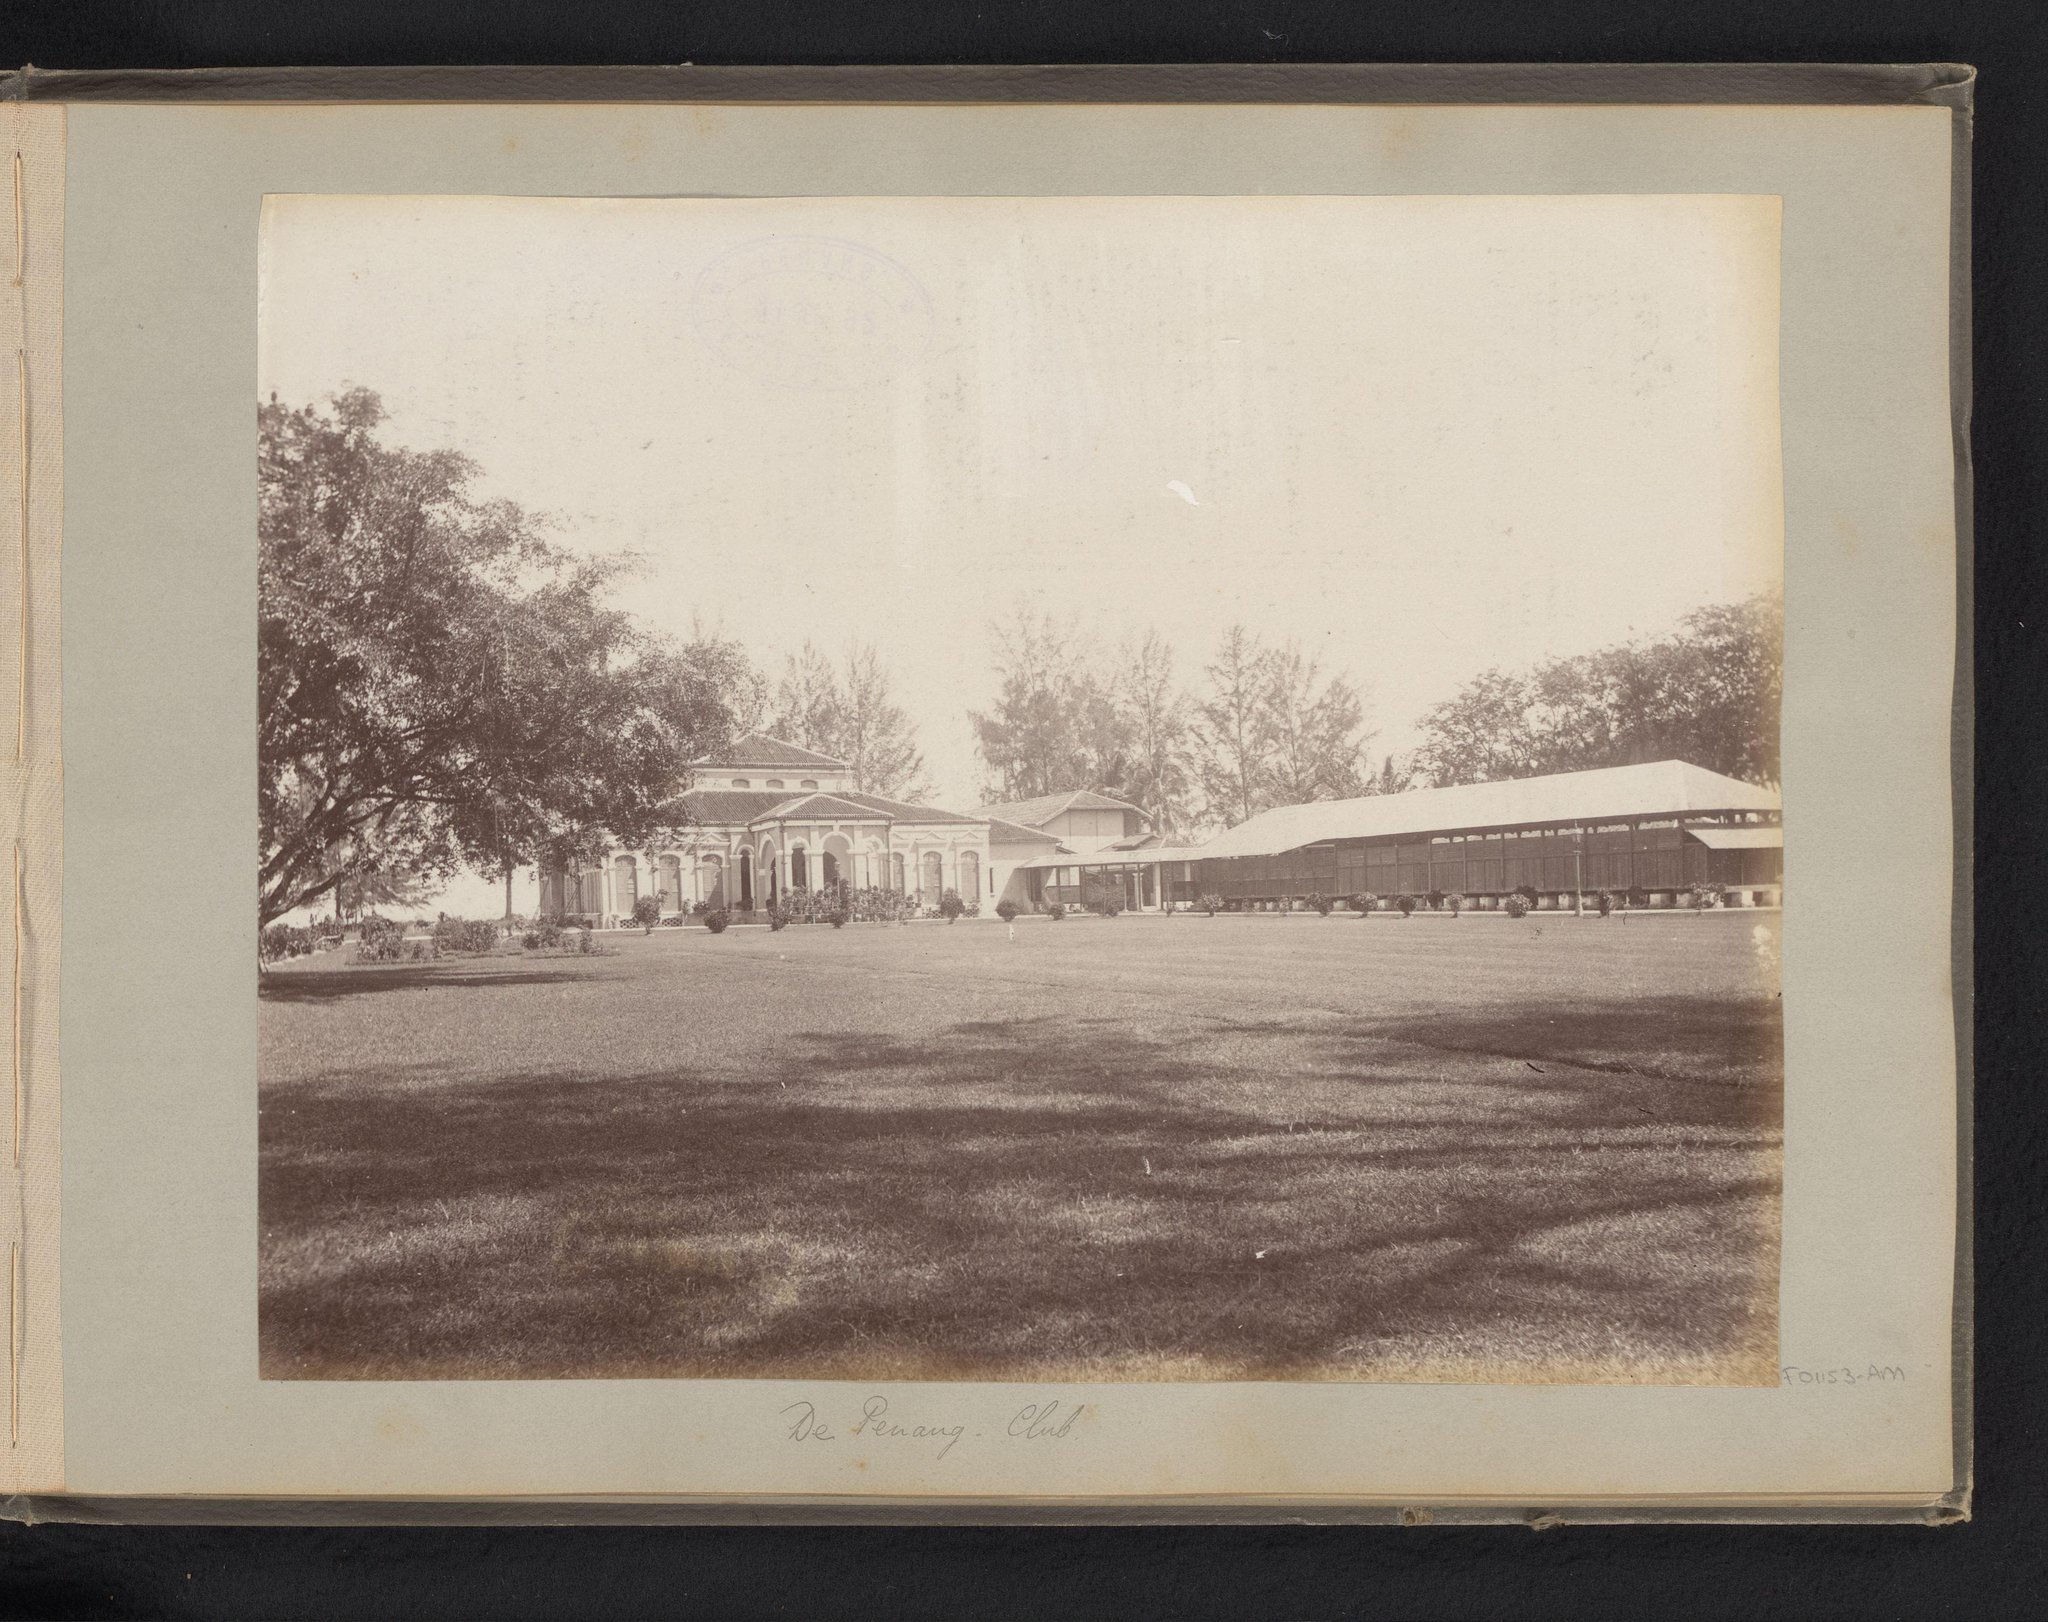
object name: photograph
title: De Penang - Club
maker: Anonymous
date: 1892-1893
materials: photographic support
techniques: albumen print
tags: civic architecture; edifices; dwellings, sumatra